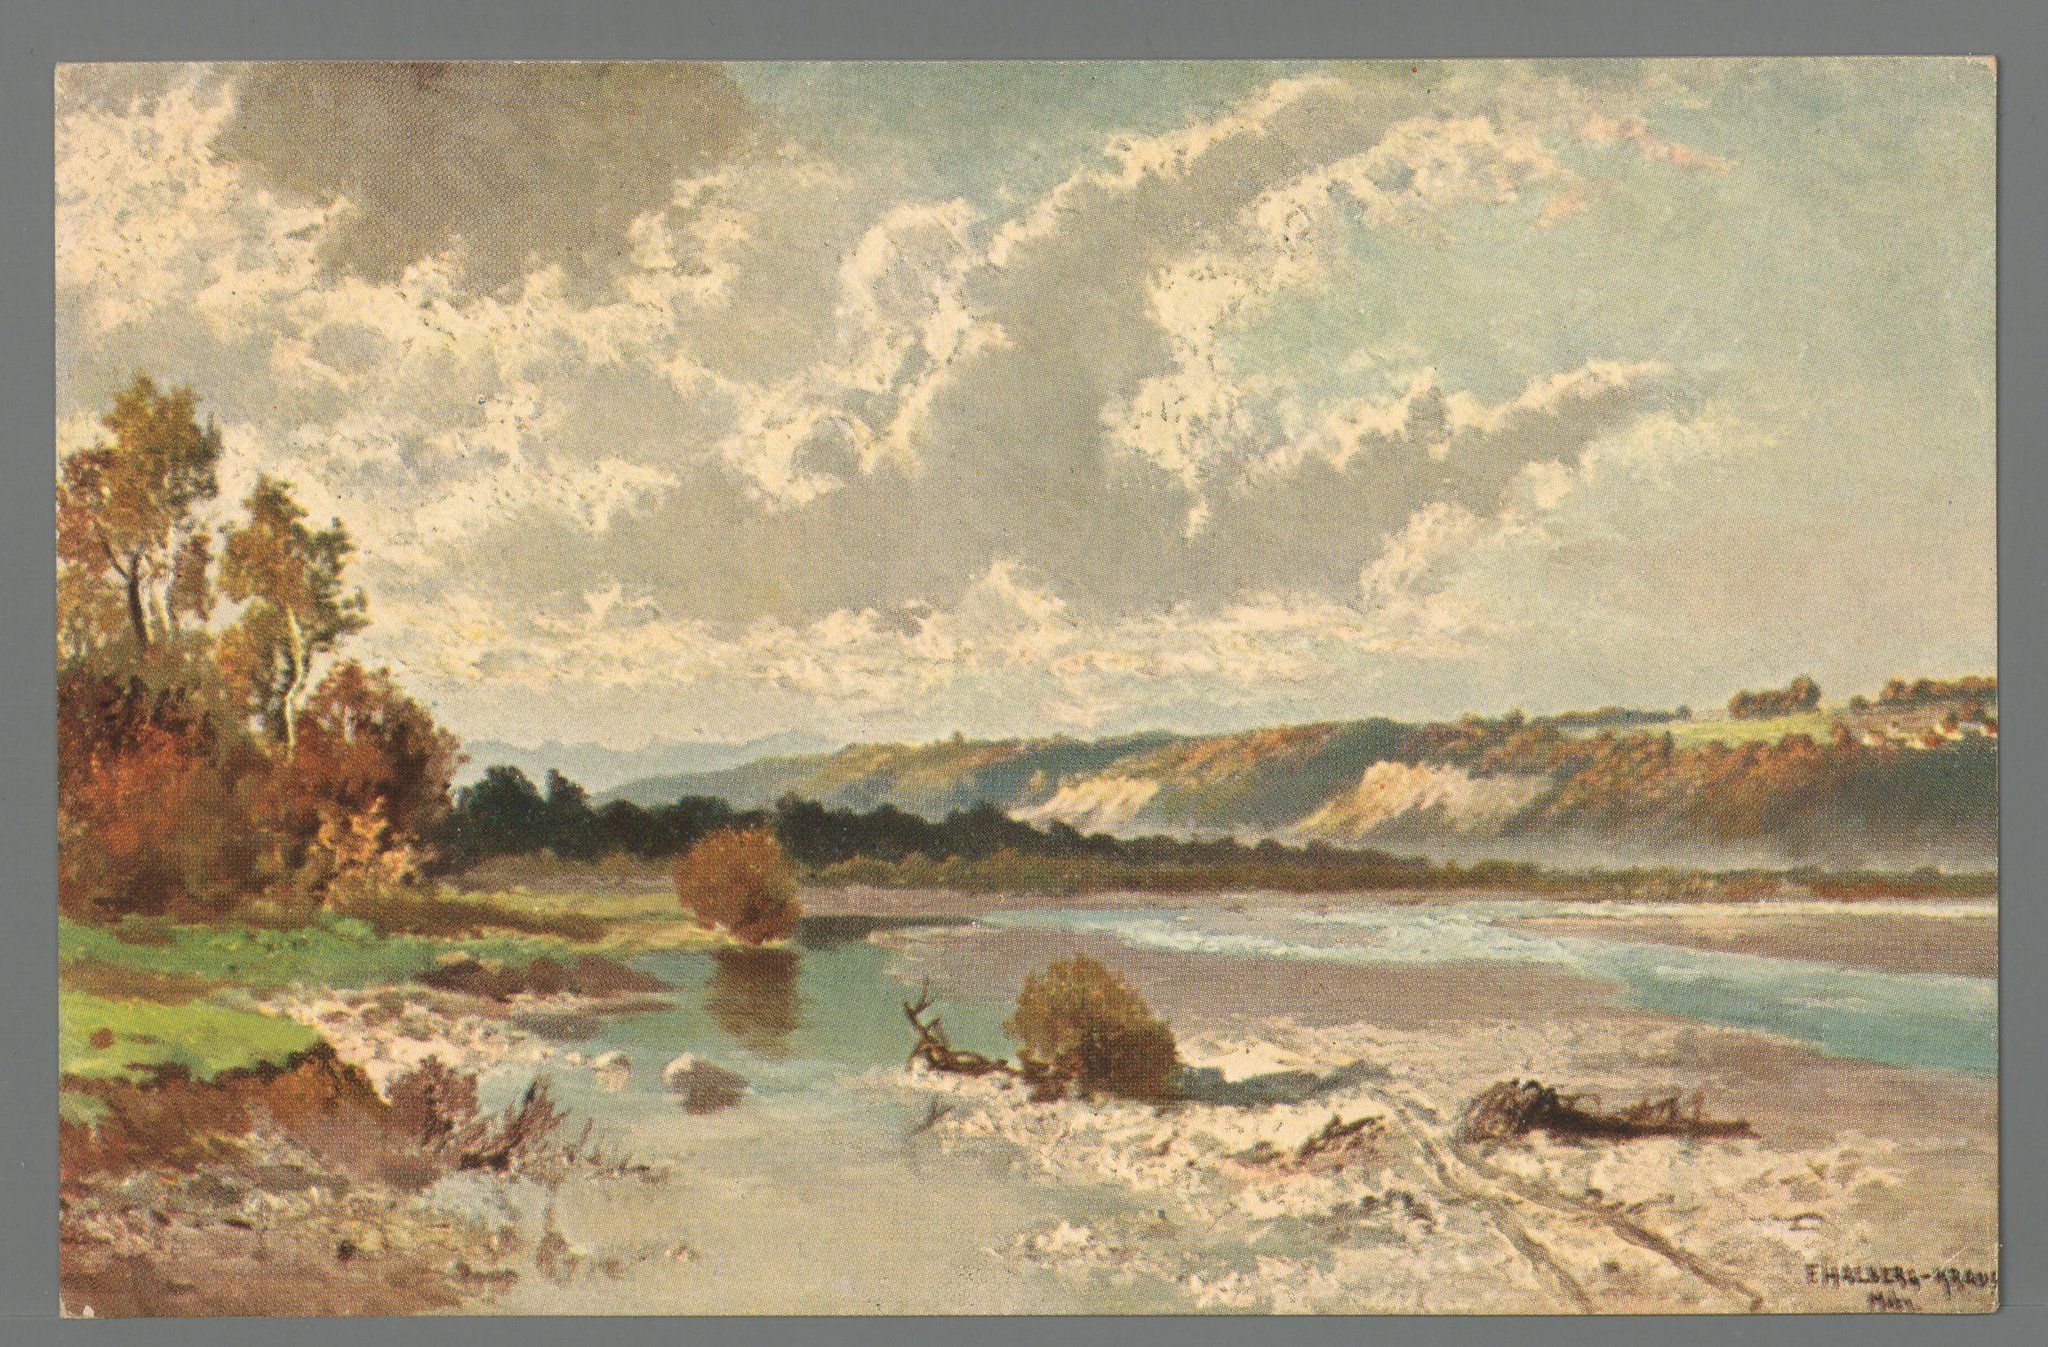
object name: reproduction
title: Langens Künstler-Karten Serie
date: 1905-1930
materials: cardboard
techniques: color autotype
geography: munich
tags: river